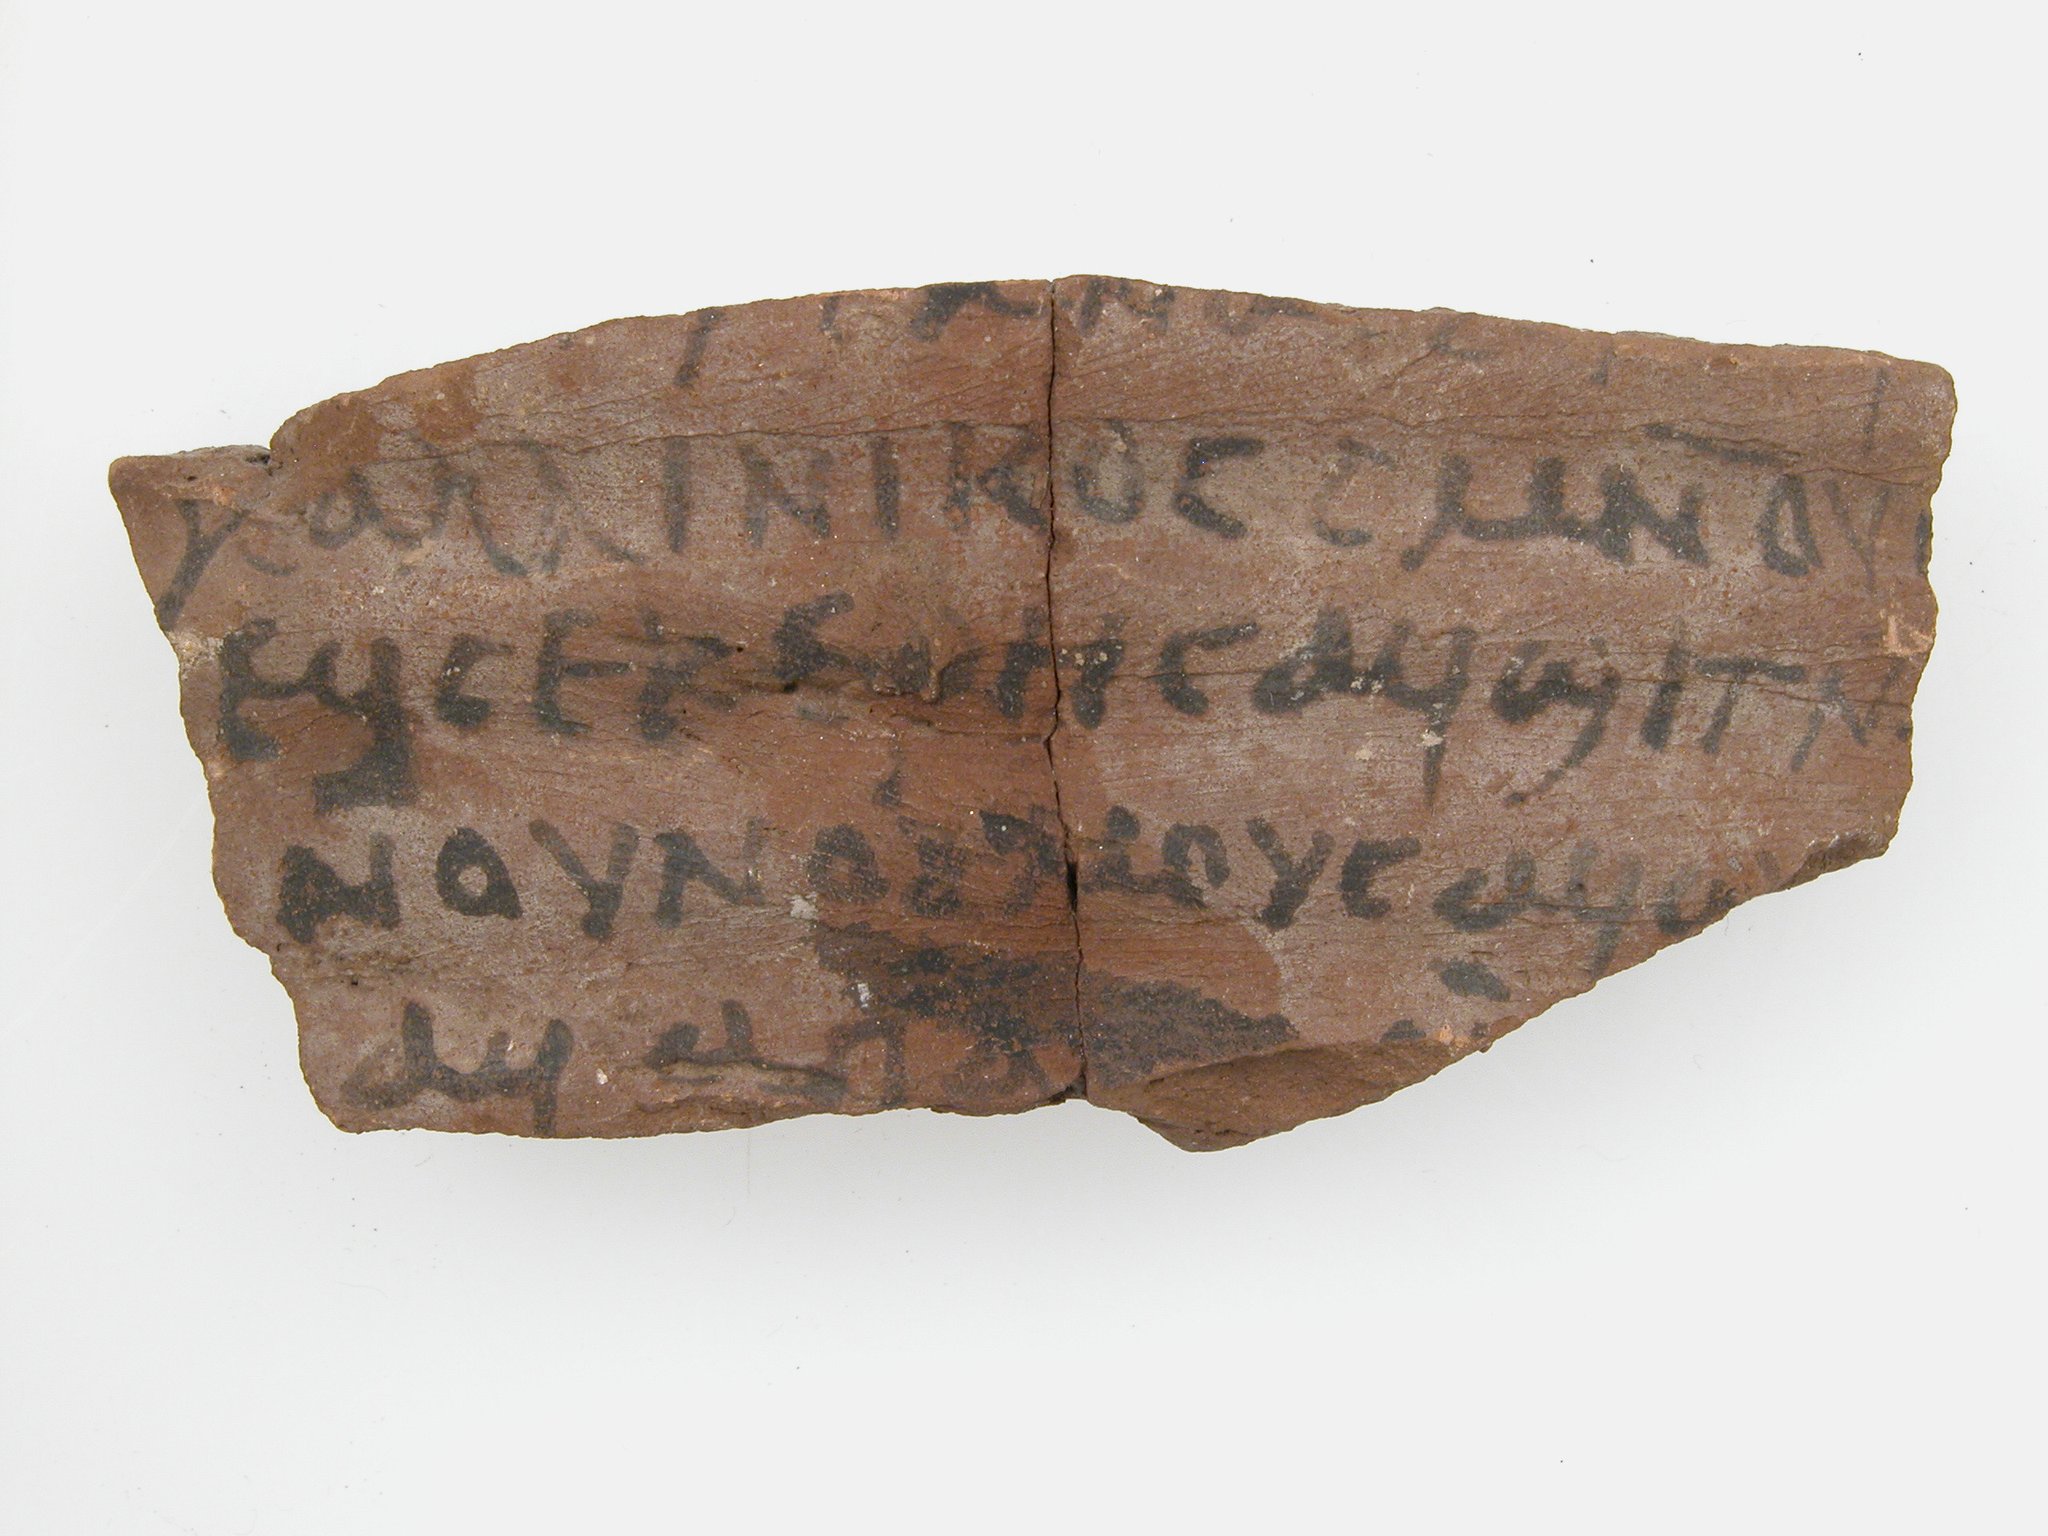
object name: ostrakon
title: Ostrakon with a Letter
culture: coptic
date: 600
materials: ink, pottery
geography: egypt